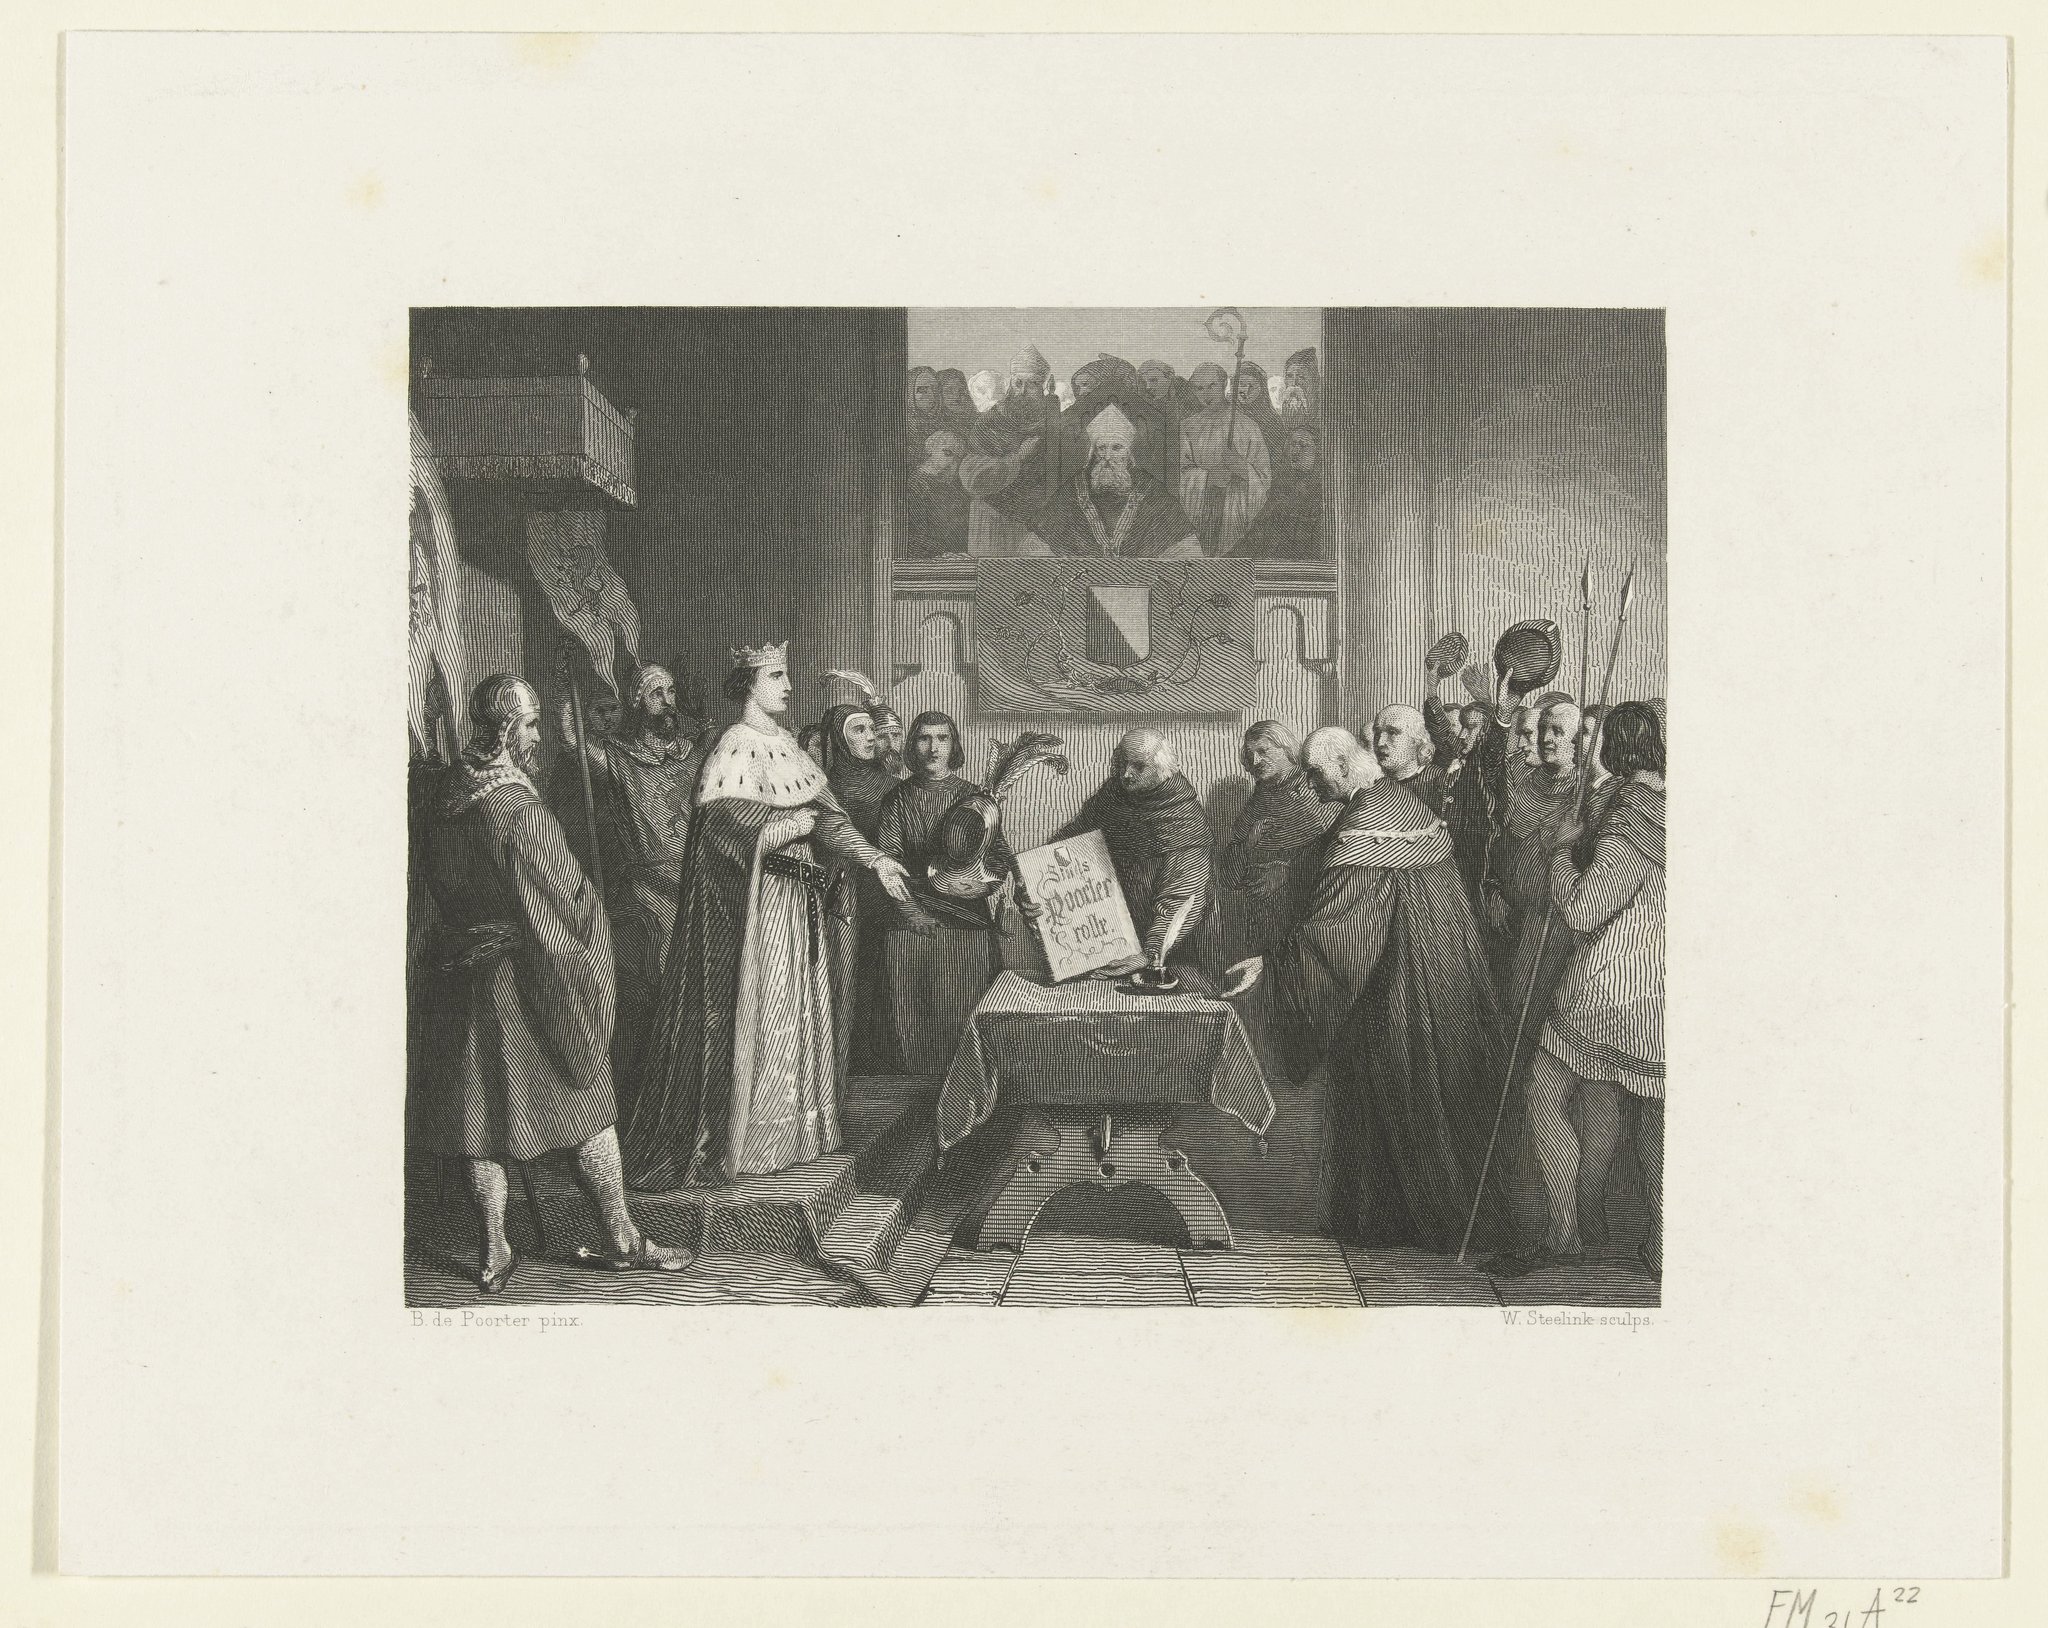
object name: print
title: Willem van Holland laat zich als poorter inschrijven te Utrecht, 1249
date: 1865-1870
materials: paper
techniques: engraving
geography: netherlands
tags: earl, utrecht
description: Illustratie voor: J. van Lennep en W. Moll en J. ter Gouw, Nederlands geschiedenis en volksleven in schetsen, A.W. Sijthoff, Leiden ca. 1870. Staalgravures naar de schilderijen van de Historische Galerij der Maatschappij Arti en Amicitiae.